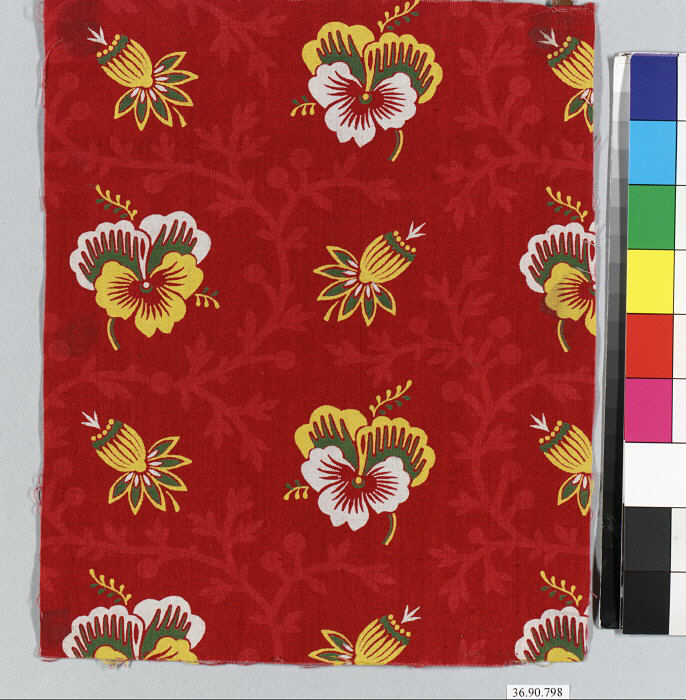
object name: piece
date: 1867-1900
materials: cotton